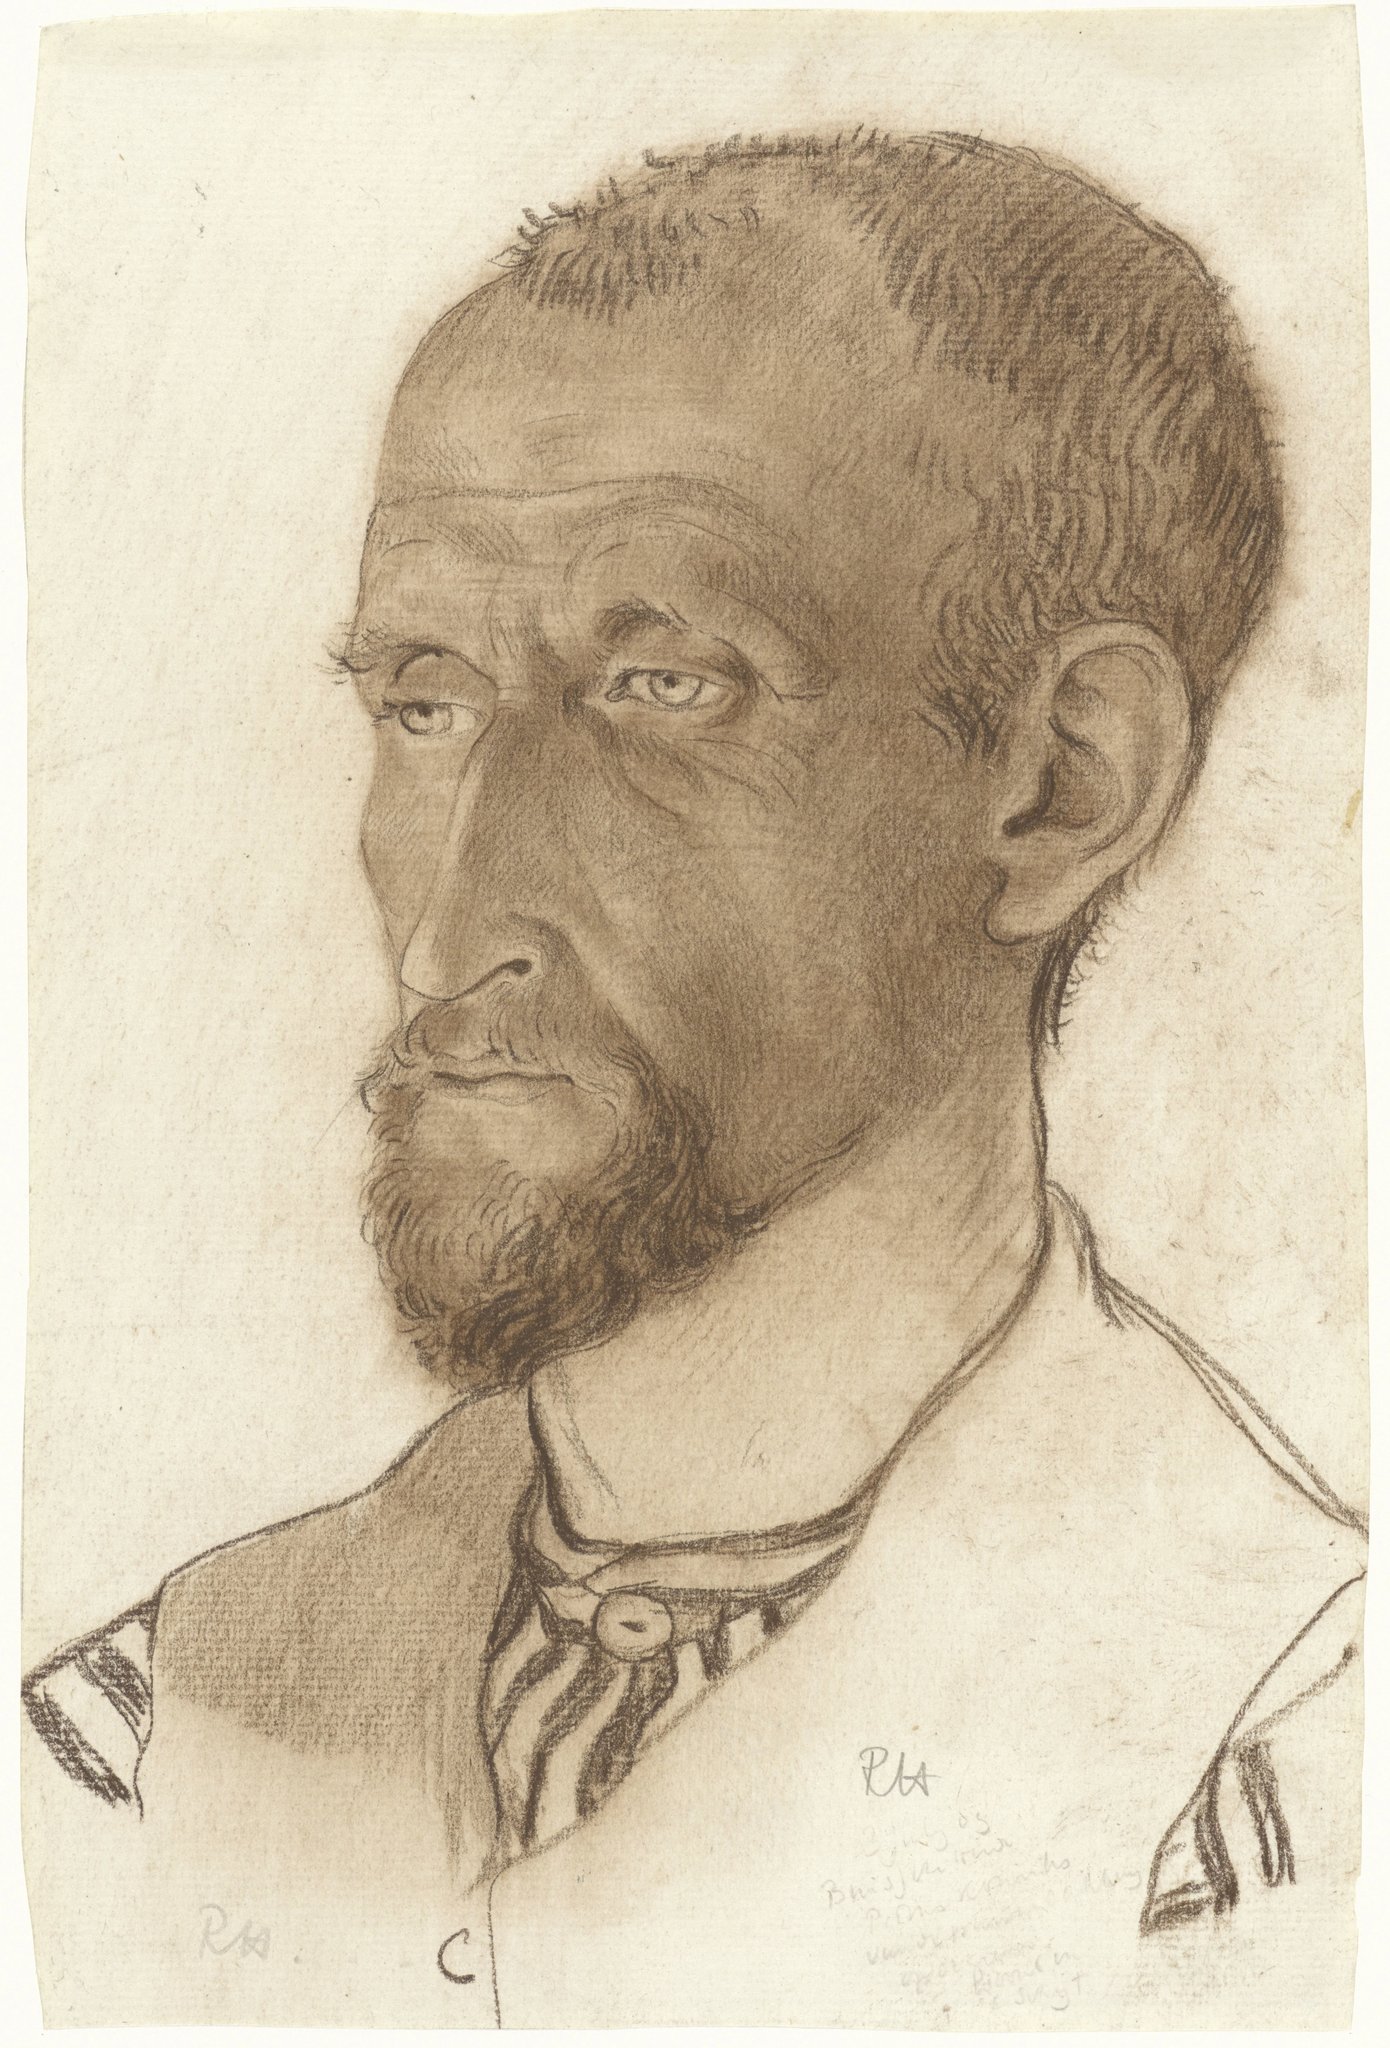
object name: drawing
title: Portret van Petrus Koninks, naar links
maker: richard nicolaüs roland holst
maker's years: 1868-1938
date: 1903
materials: chalk, paper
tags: historical persons, portrait, self-portrait of artist